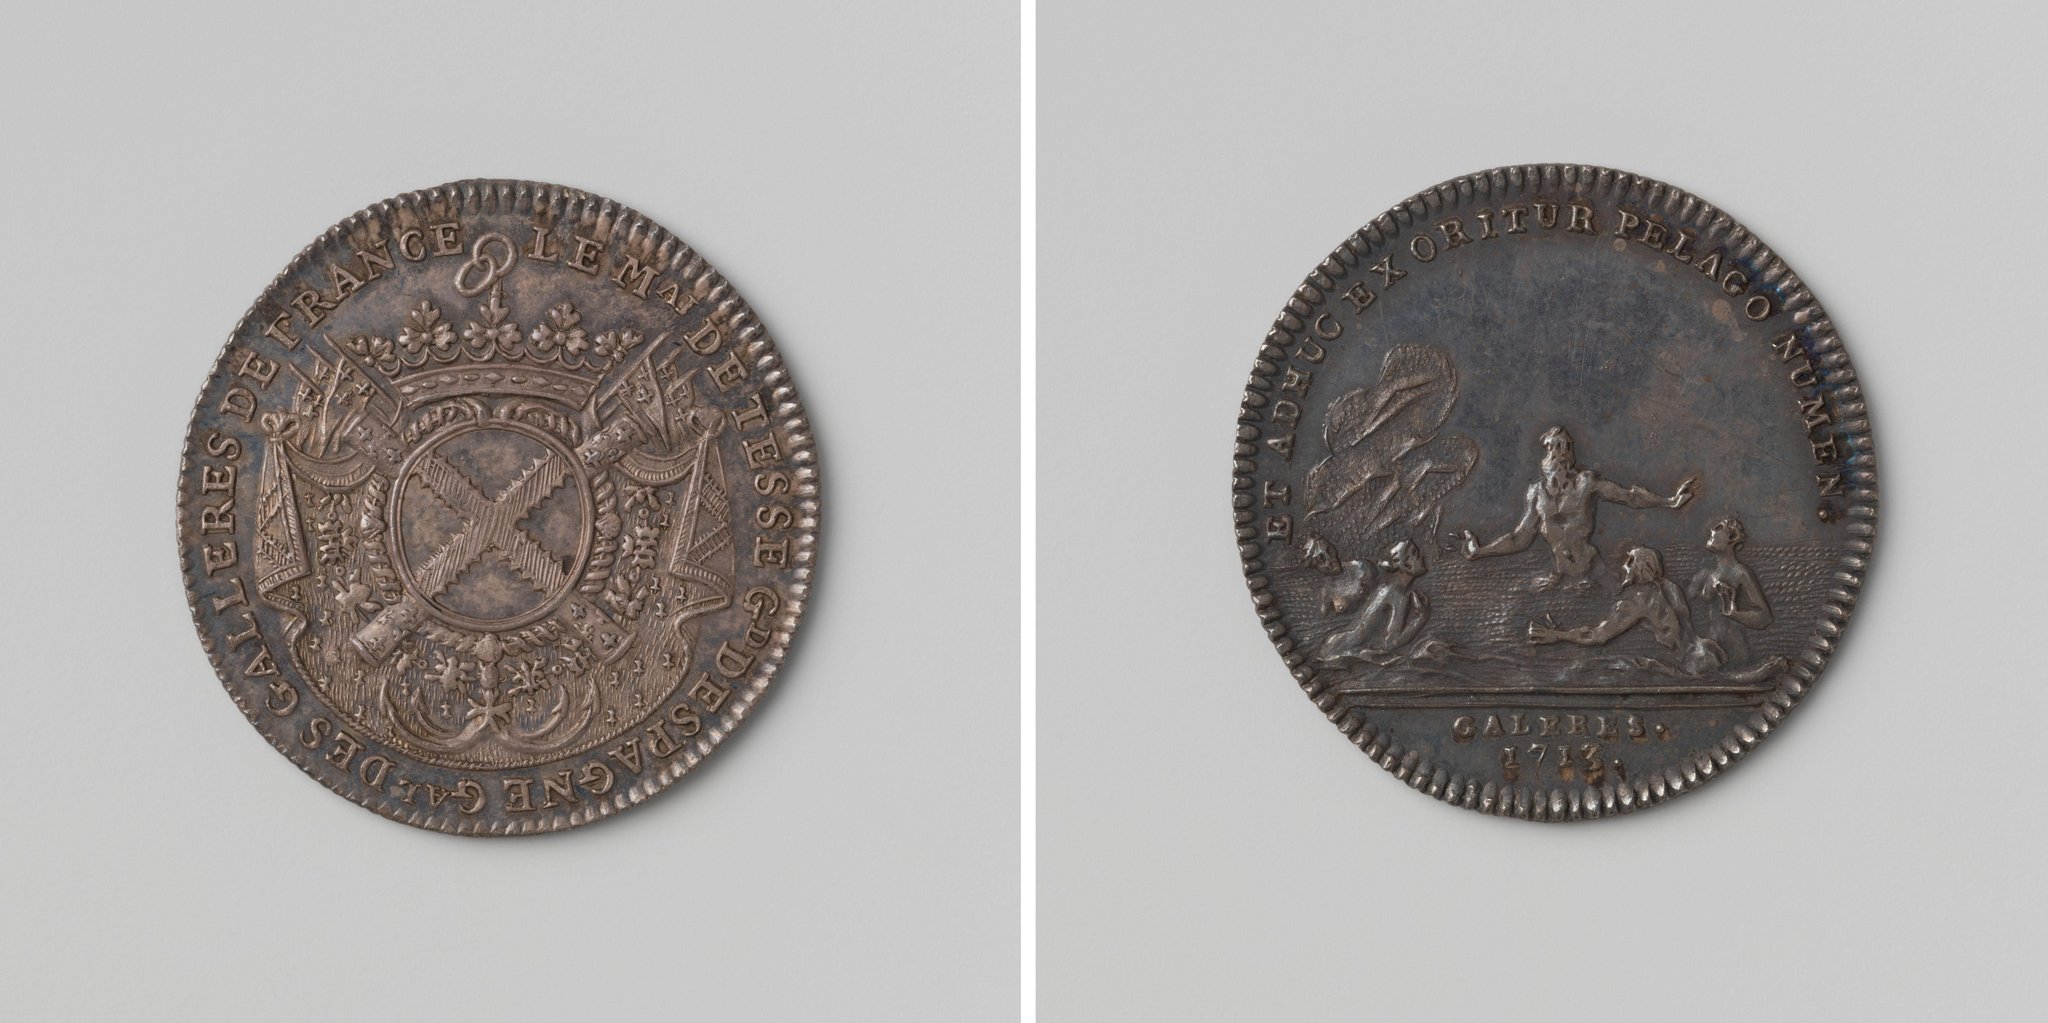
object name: jeton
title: Wapenstilstand tussen Engeland en Frankrijk, rekenpenning geslagen ter ere van Rene de Froulay, graaf van Tesse, maarschalk van Frankrijk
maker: Anonymous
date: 1713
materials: silver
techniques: striking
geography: france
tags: maarschalk, rene de froulay (graaf van tesse), spaanse successieoorlog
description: Zilveren penning. Voorzijde: gekroond wapenschild op hermelijnen mantel binnen omschrift. Keerzijde: zeegodin, vergezeld door verschillende nymphen komt Neptunus te hulp binnen omschrift; afsnede: opschrift